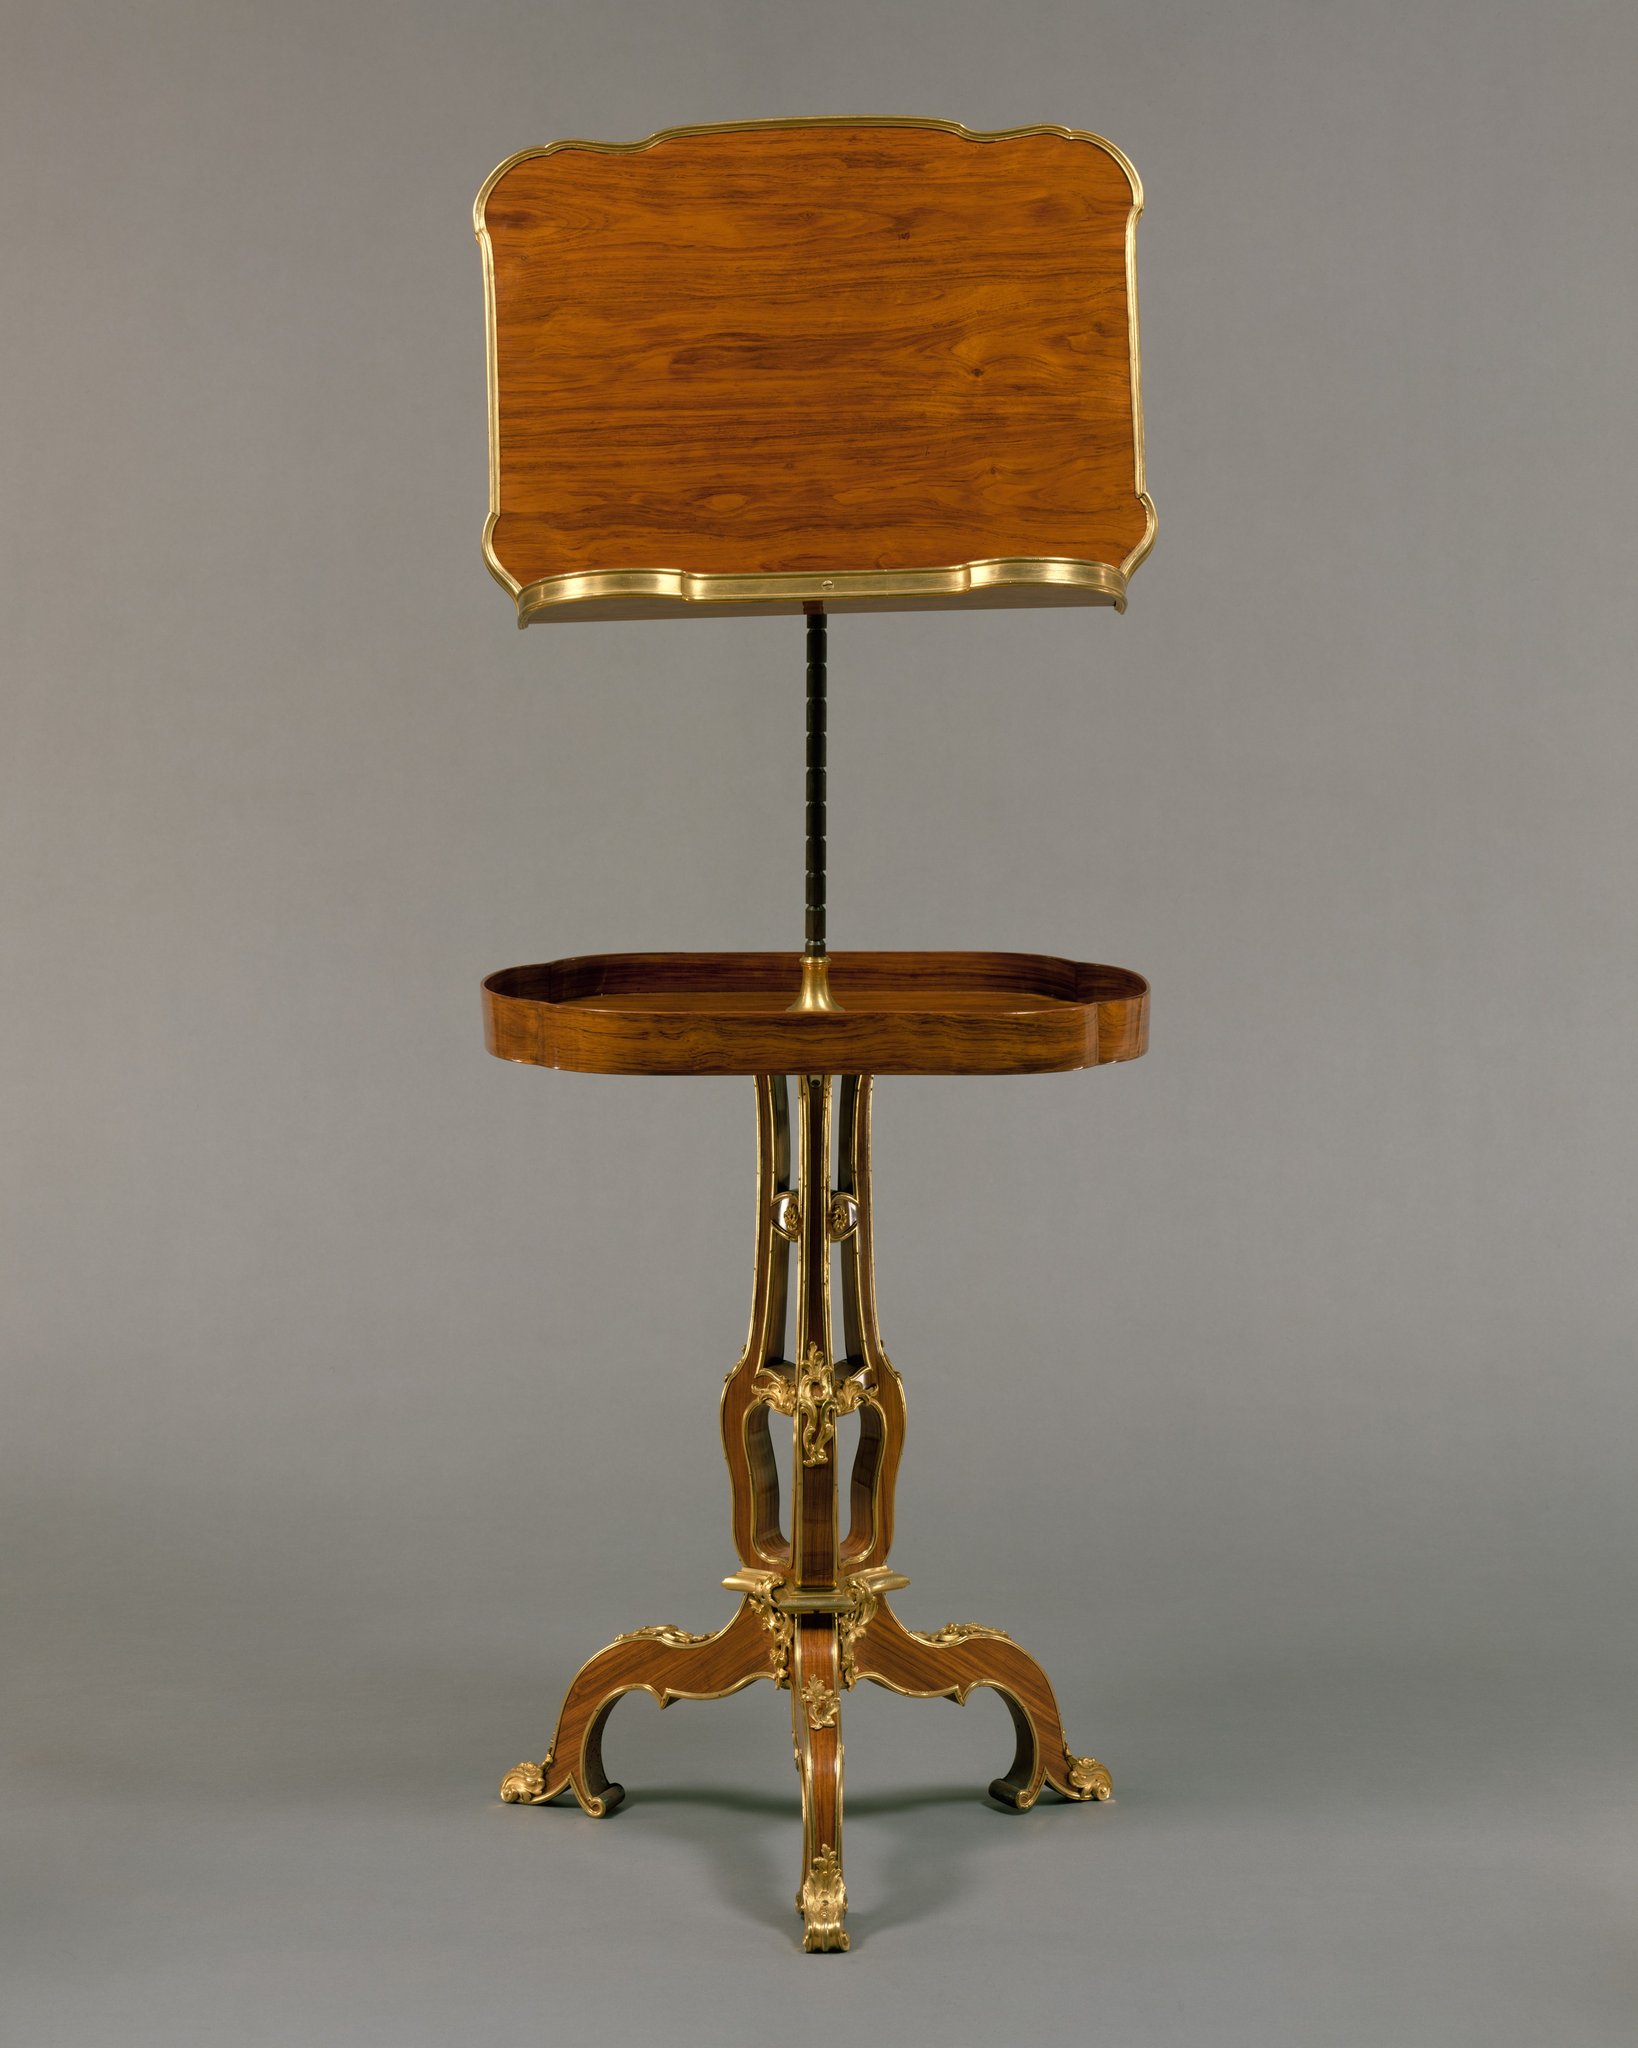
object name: reading and writing table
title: Adjustable reading and writing table (pupitre à crémaillère, servant de table)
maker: martin carlin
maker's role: maker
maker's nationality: french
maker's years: 1725-1785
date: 1760-1765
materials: brass, gilt bronze, steel, wood